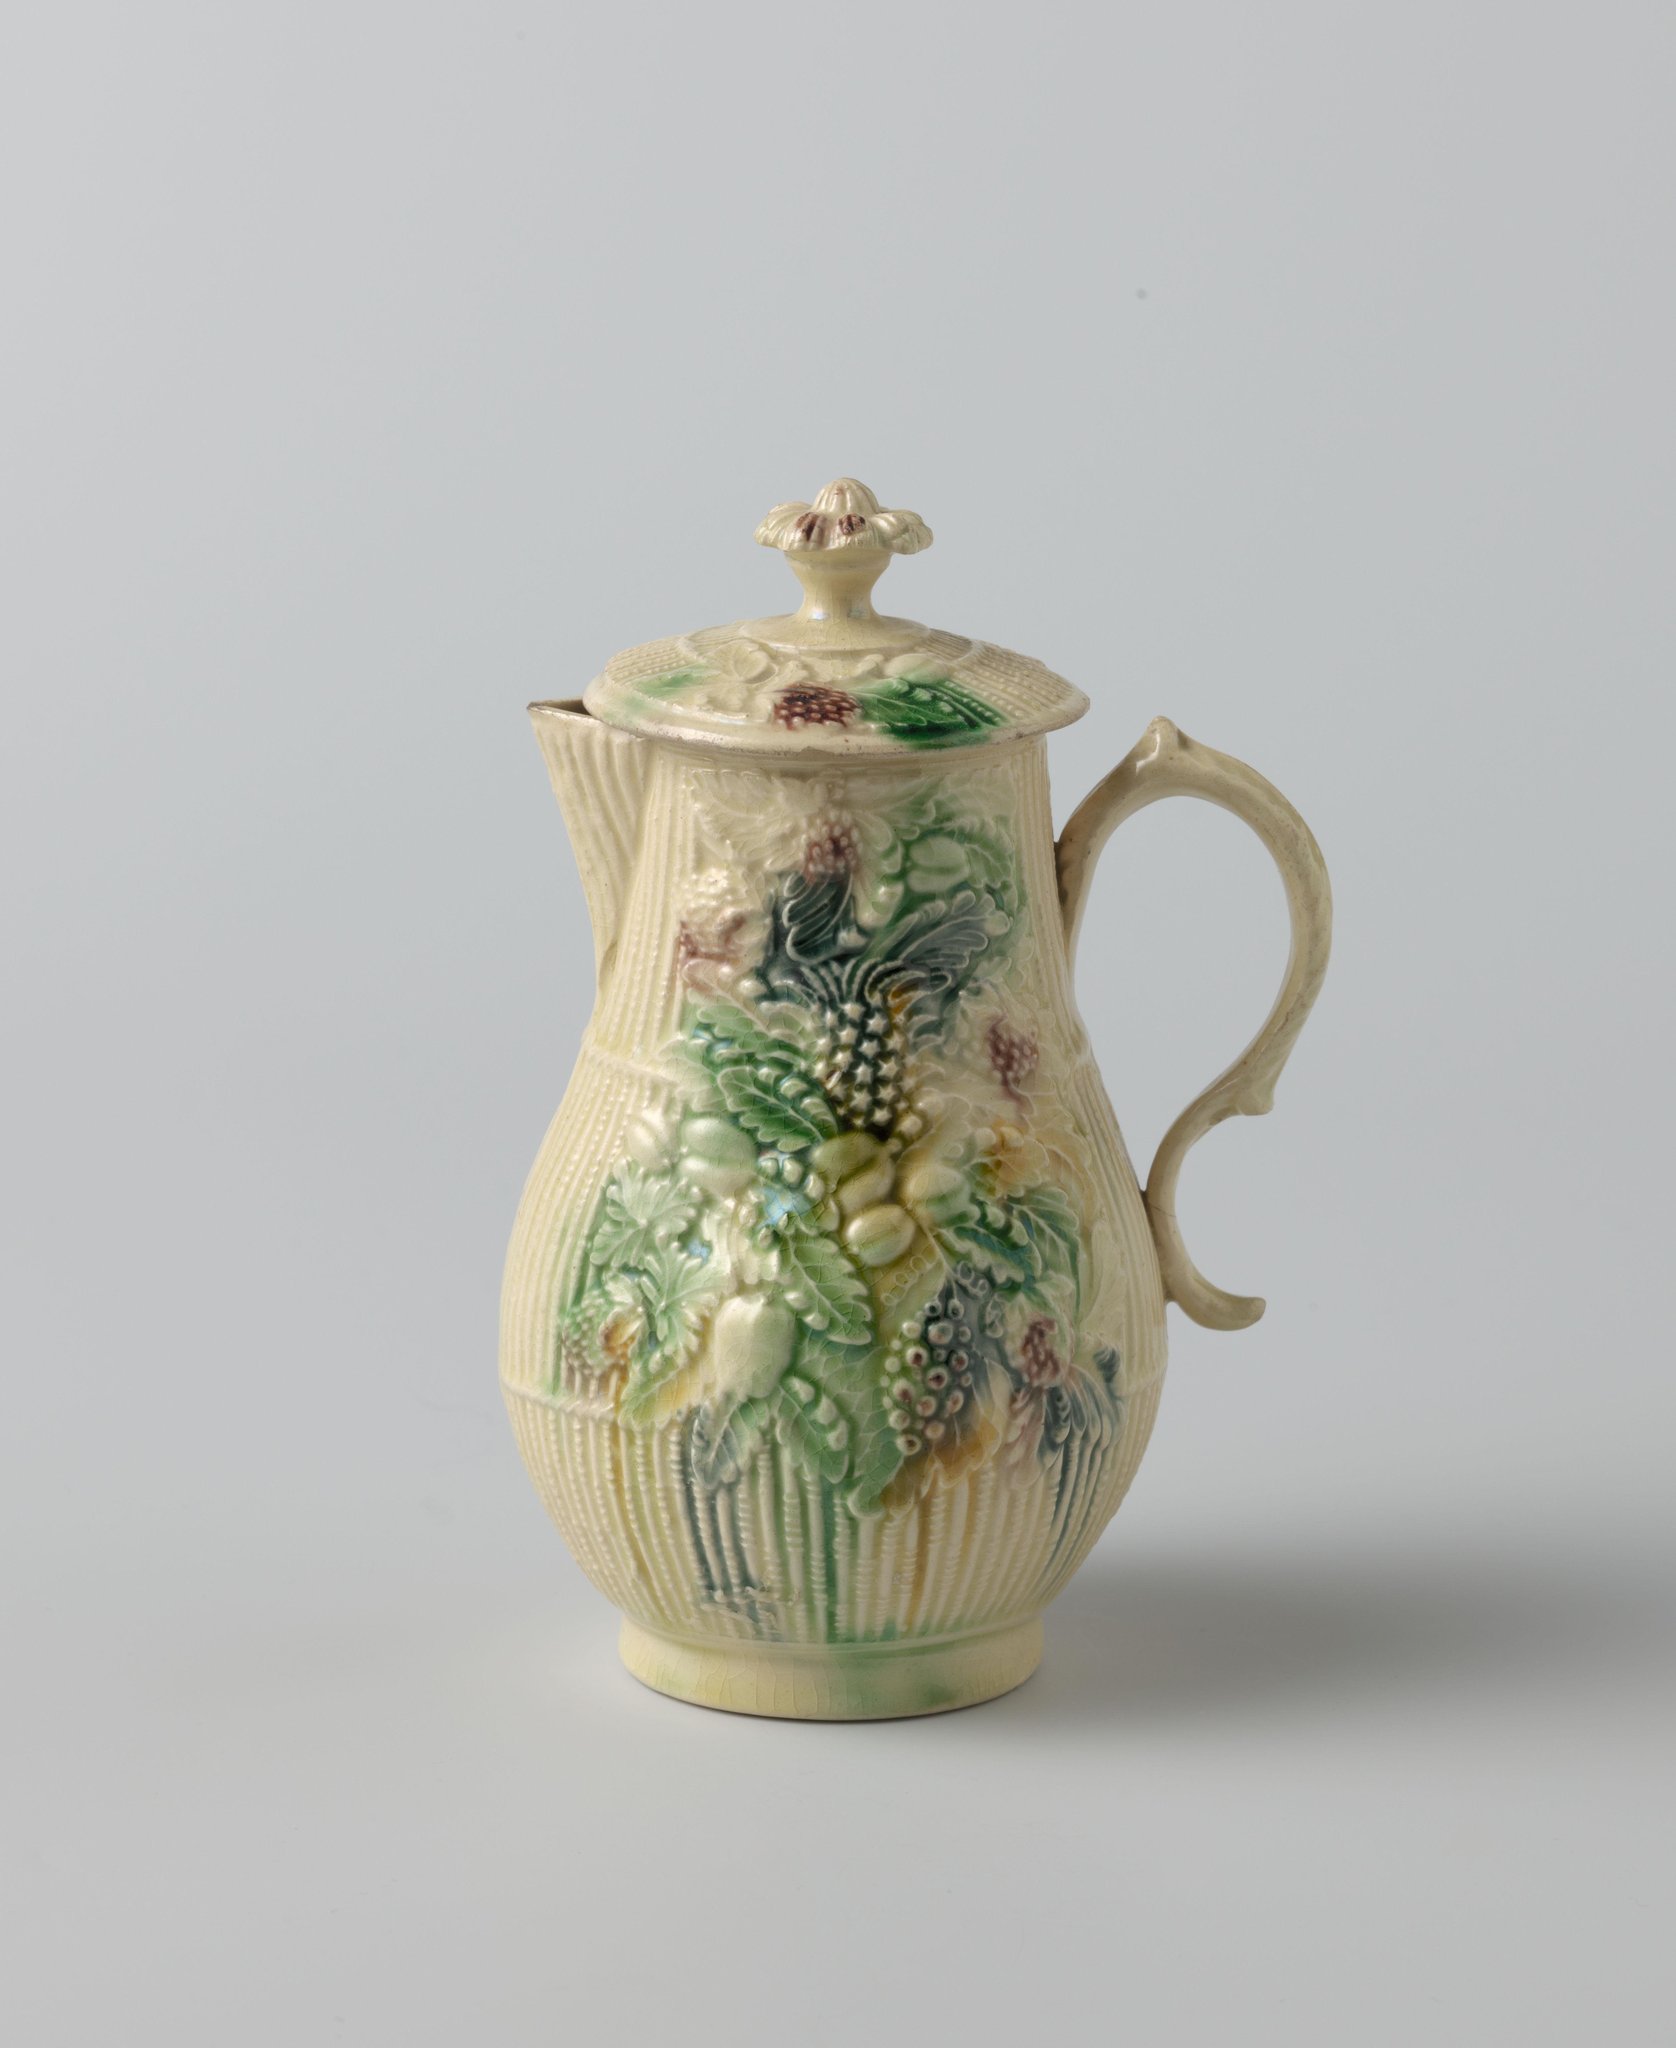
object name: lid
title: Deksel van hardgebakken aardewerk.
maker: Anonymous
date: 1770-1775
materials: earthenware, glaze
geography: derby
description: Deksel van hardgebakken aardewerk, bedekt met loodglazuur in groen, geel, blauw en mangaan en versierd met druiventrossen en bladeren in reliëf. Het oppervlak is verticaal geribd. De knop in de vorm van een bloem.